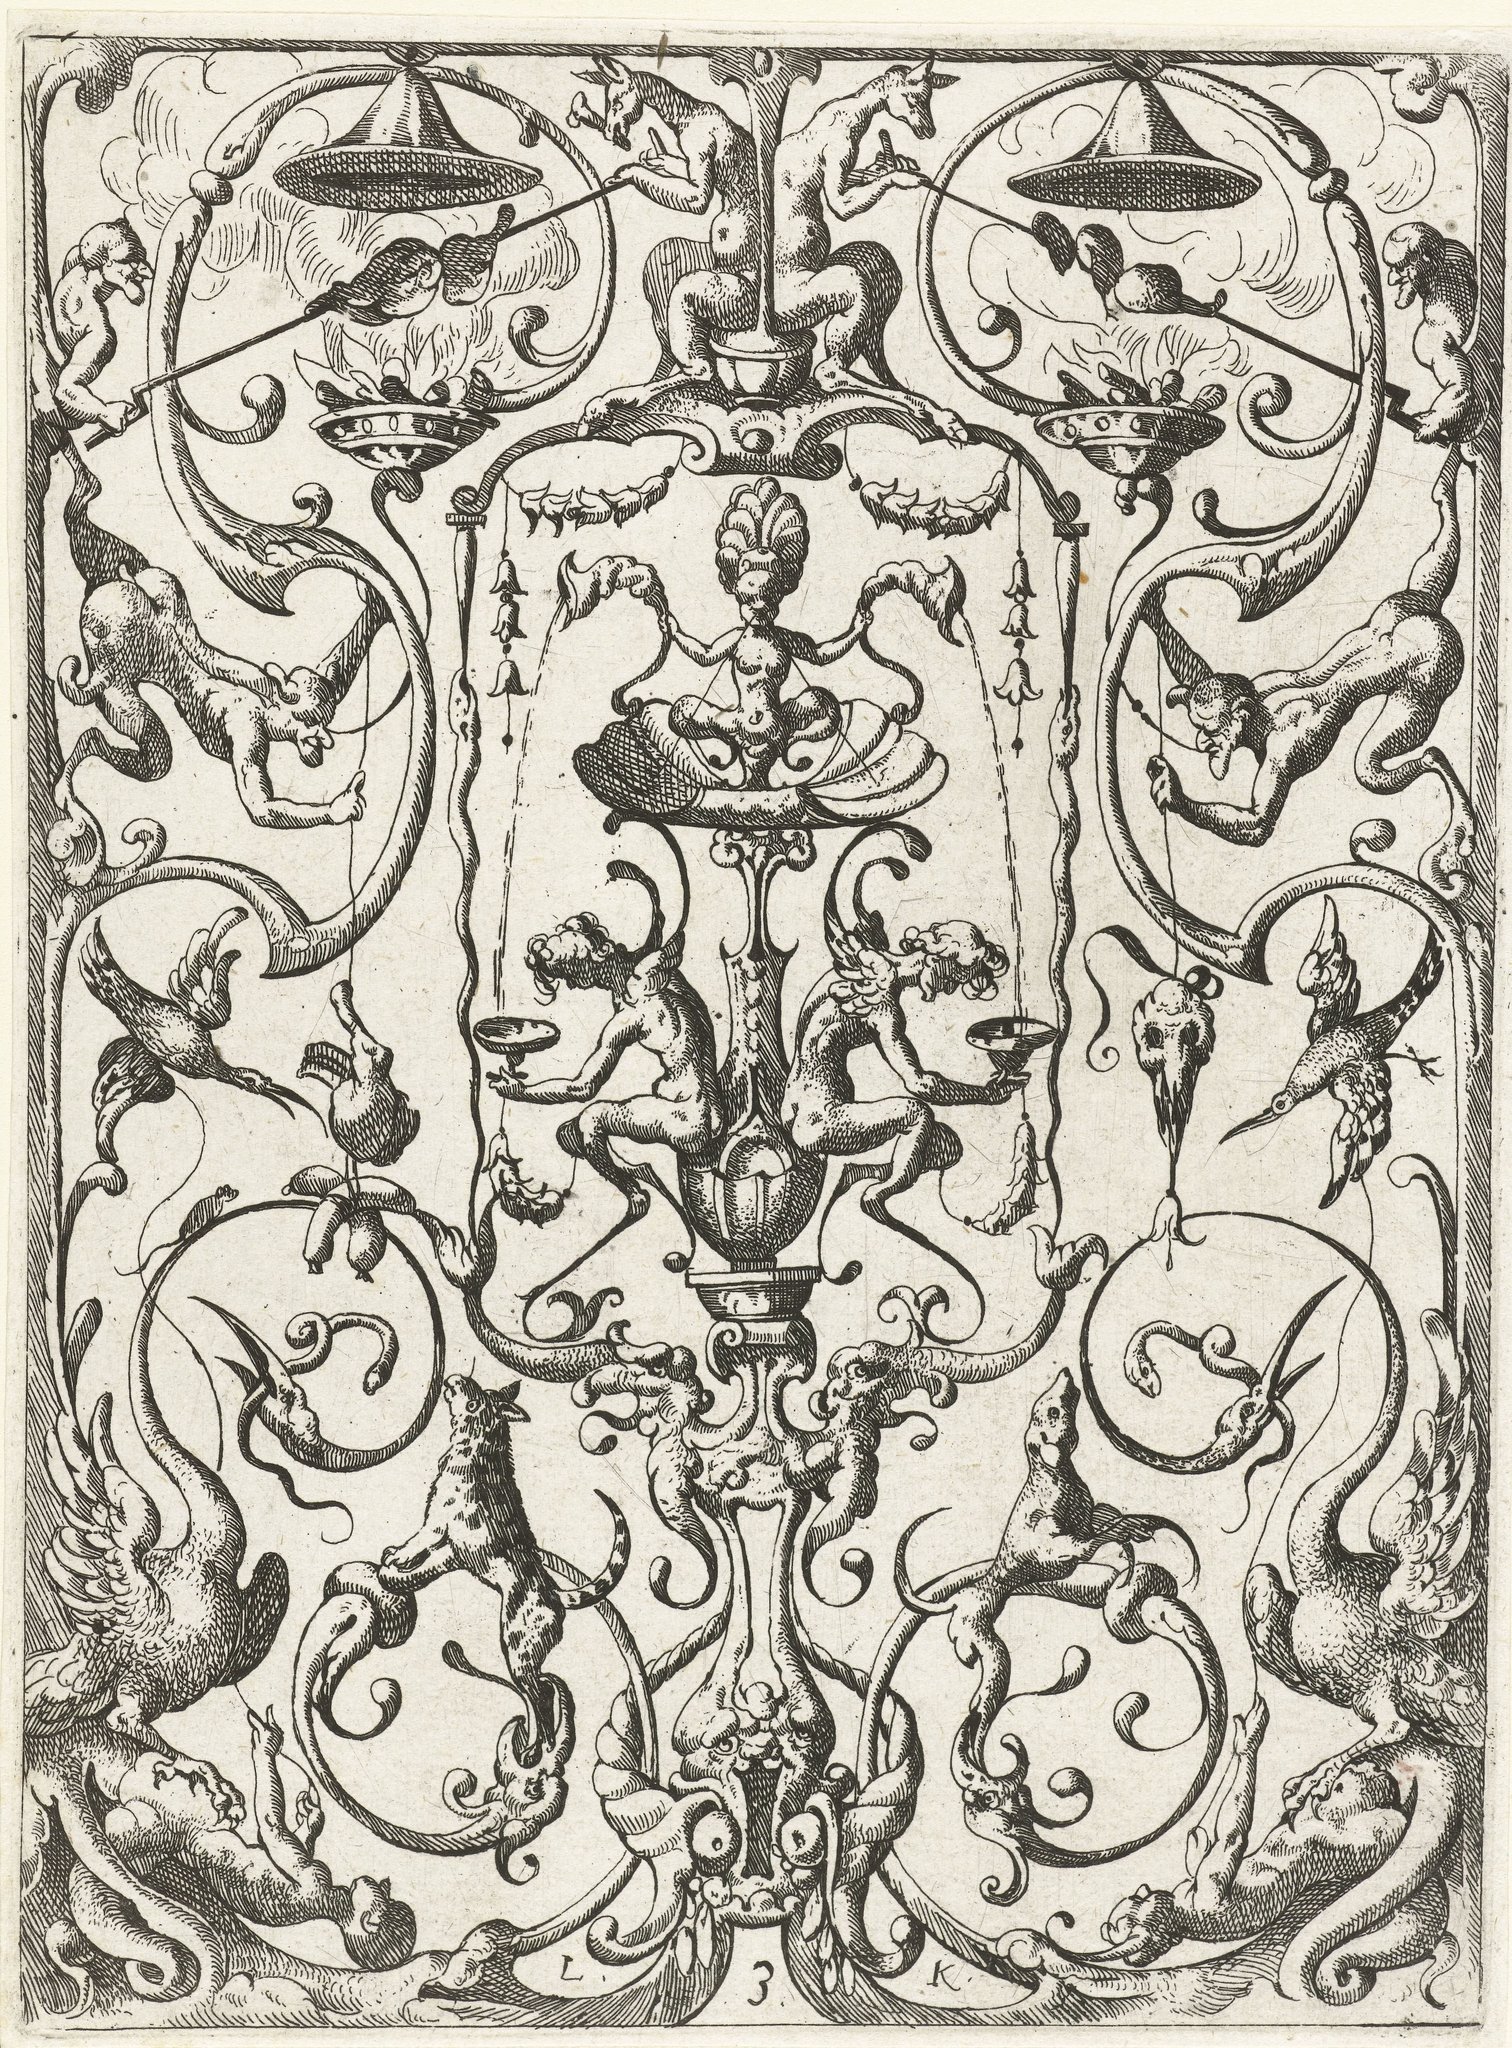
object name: print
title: Vlakdecoratie met grotesken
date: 1607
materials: paper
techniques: etching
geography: germany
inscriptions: collector's mark: Lugt 240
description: In het midden giet een figuur vloeistof vanuit twee hoorns in tazze vastgehouden door twee gevleugelde wezens. Blad 3 uit serie met groteske vlakdecoraties met kwabornamenten.